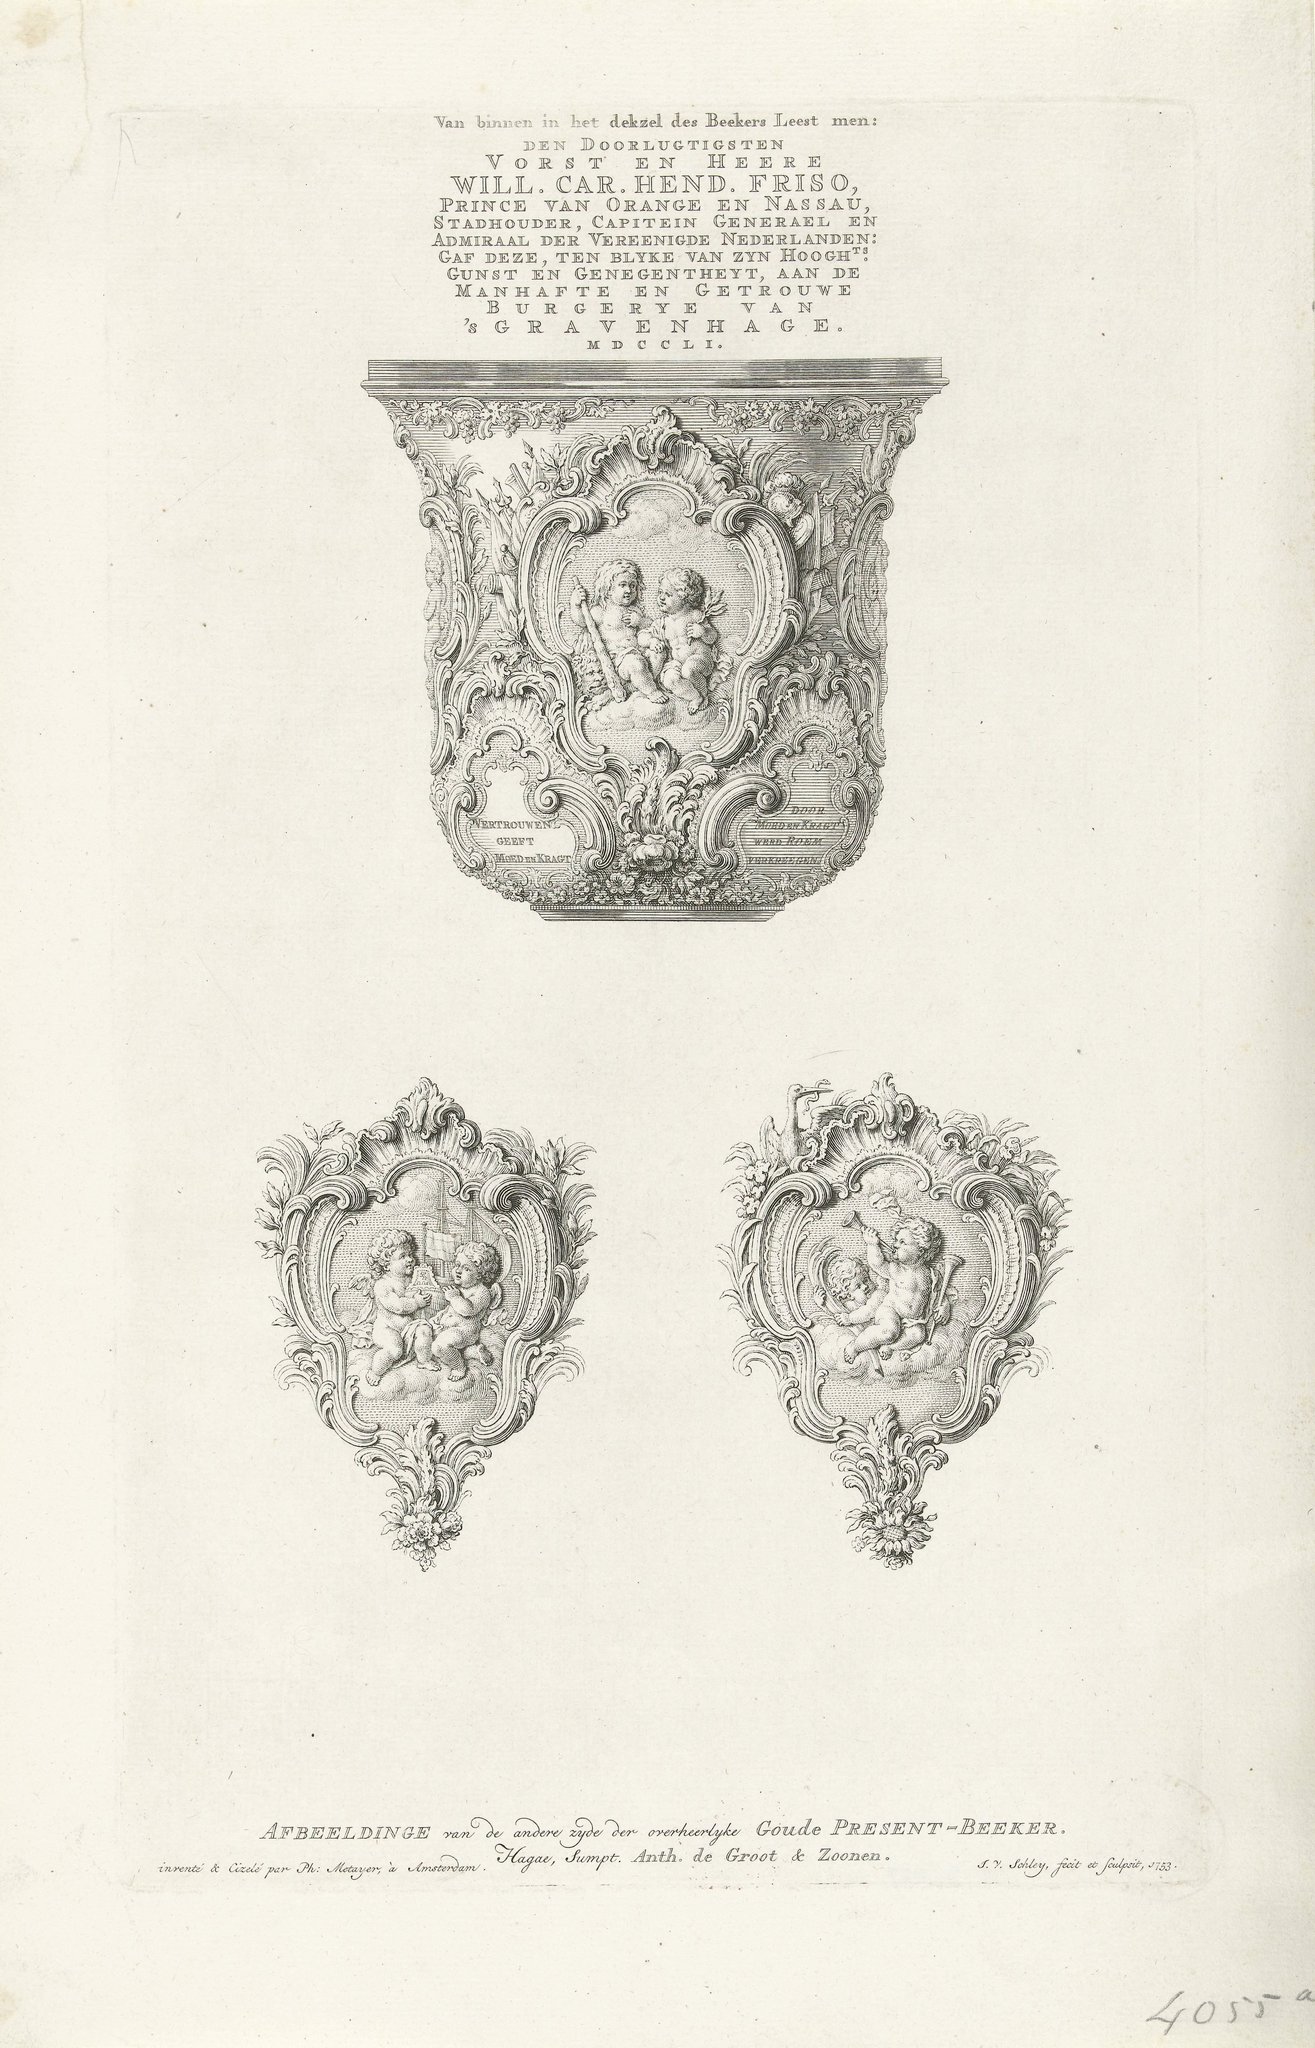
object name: print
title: Afbeeldinge van de andere zyde der overheerlyke Goude Present-Beeker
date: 1753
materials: paper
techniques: etching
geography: northern netherlands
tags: willem iv (prins van oranje-nassau), anna van hannover, cup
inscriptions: collector's mark: Lugt 240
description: Een gouden beker door stadhouder Willem IV toegezegd aan de Haagse schutterij en na zijn dood gepresenteerd door prinses Anna op 8 mei 1753. Blad met drie details van de voorstellingen op de beker en de inscriptie aangebracht aan de binnenzijde van de deksel. De beker vervaardigd door Philippe Métayer te Amsterdam.